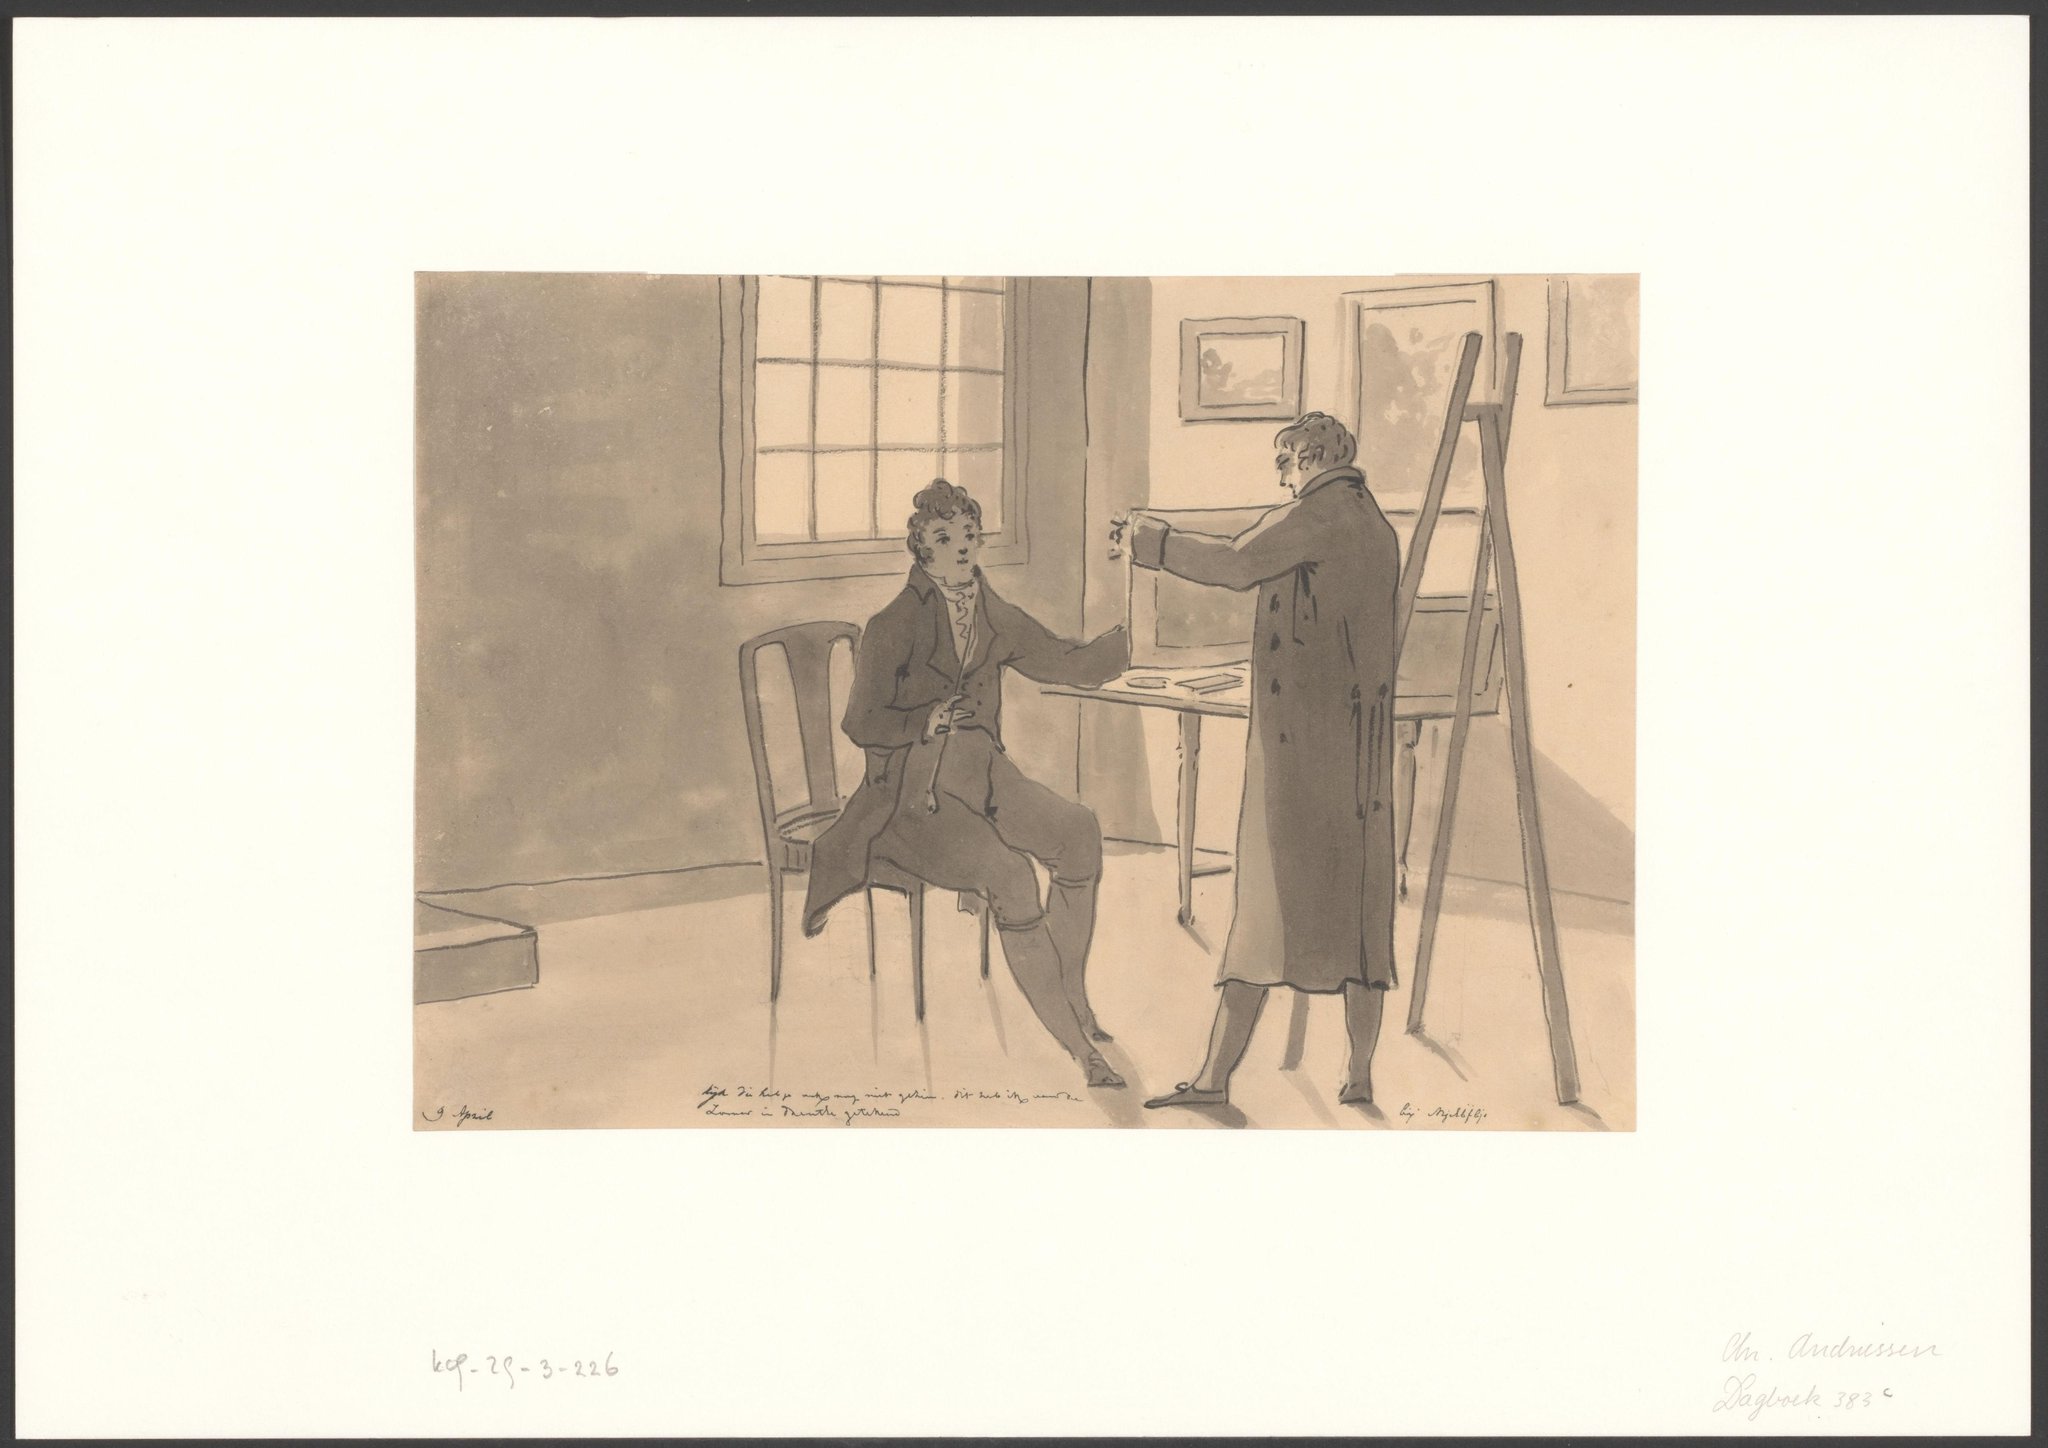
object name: drawing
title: Gerrit Jan Michaëlis toont Christiaan Andriessen eigen werk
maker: christiaan andriessen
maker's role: draughtsman, print maker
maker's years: 1775-1846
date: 1806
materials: ink, paper, pencil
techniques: brush, pen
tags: christiaan andriessen, amsterdam, haarlem, painter, print maker, draughtsman, gerrit jan michaëlis, drawing, sketch, workshop, studio ~ painter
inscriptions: signature: ‘J Andriessen’, inscription: ‘9 April Kijk die heb je ook nog niet gezien. Dit heb ik naar die Zomer in d.... getekend’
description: Dagboekblad uit het getekende dagboek dat Christiaan Andriessen bijhield van 1805 tot en met 1808.